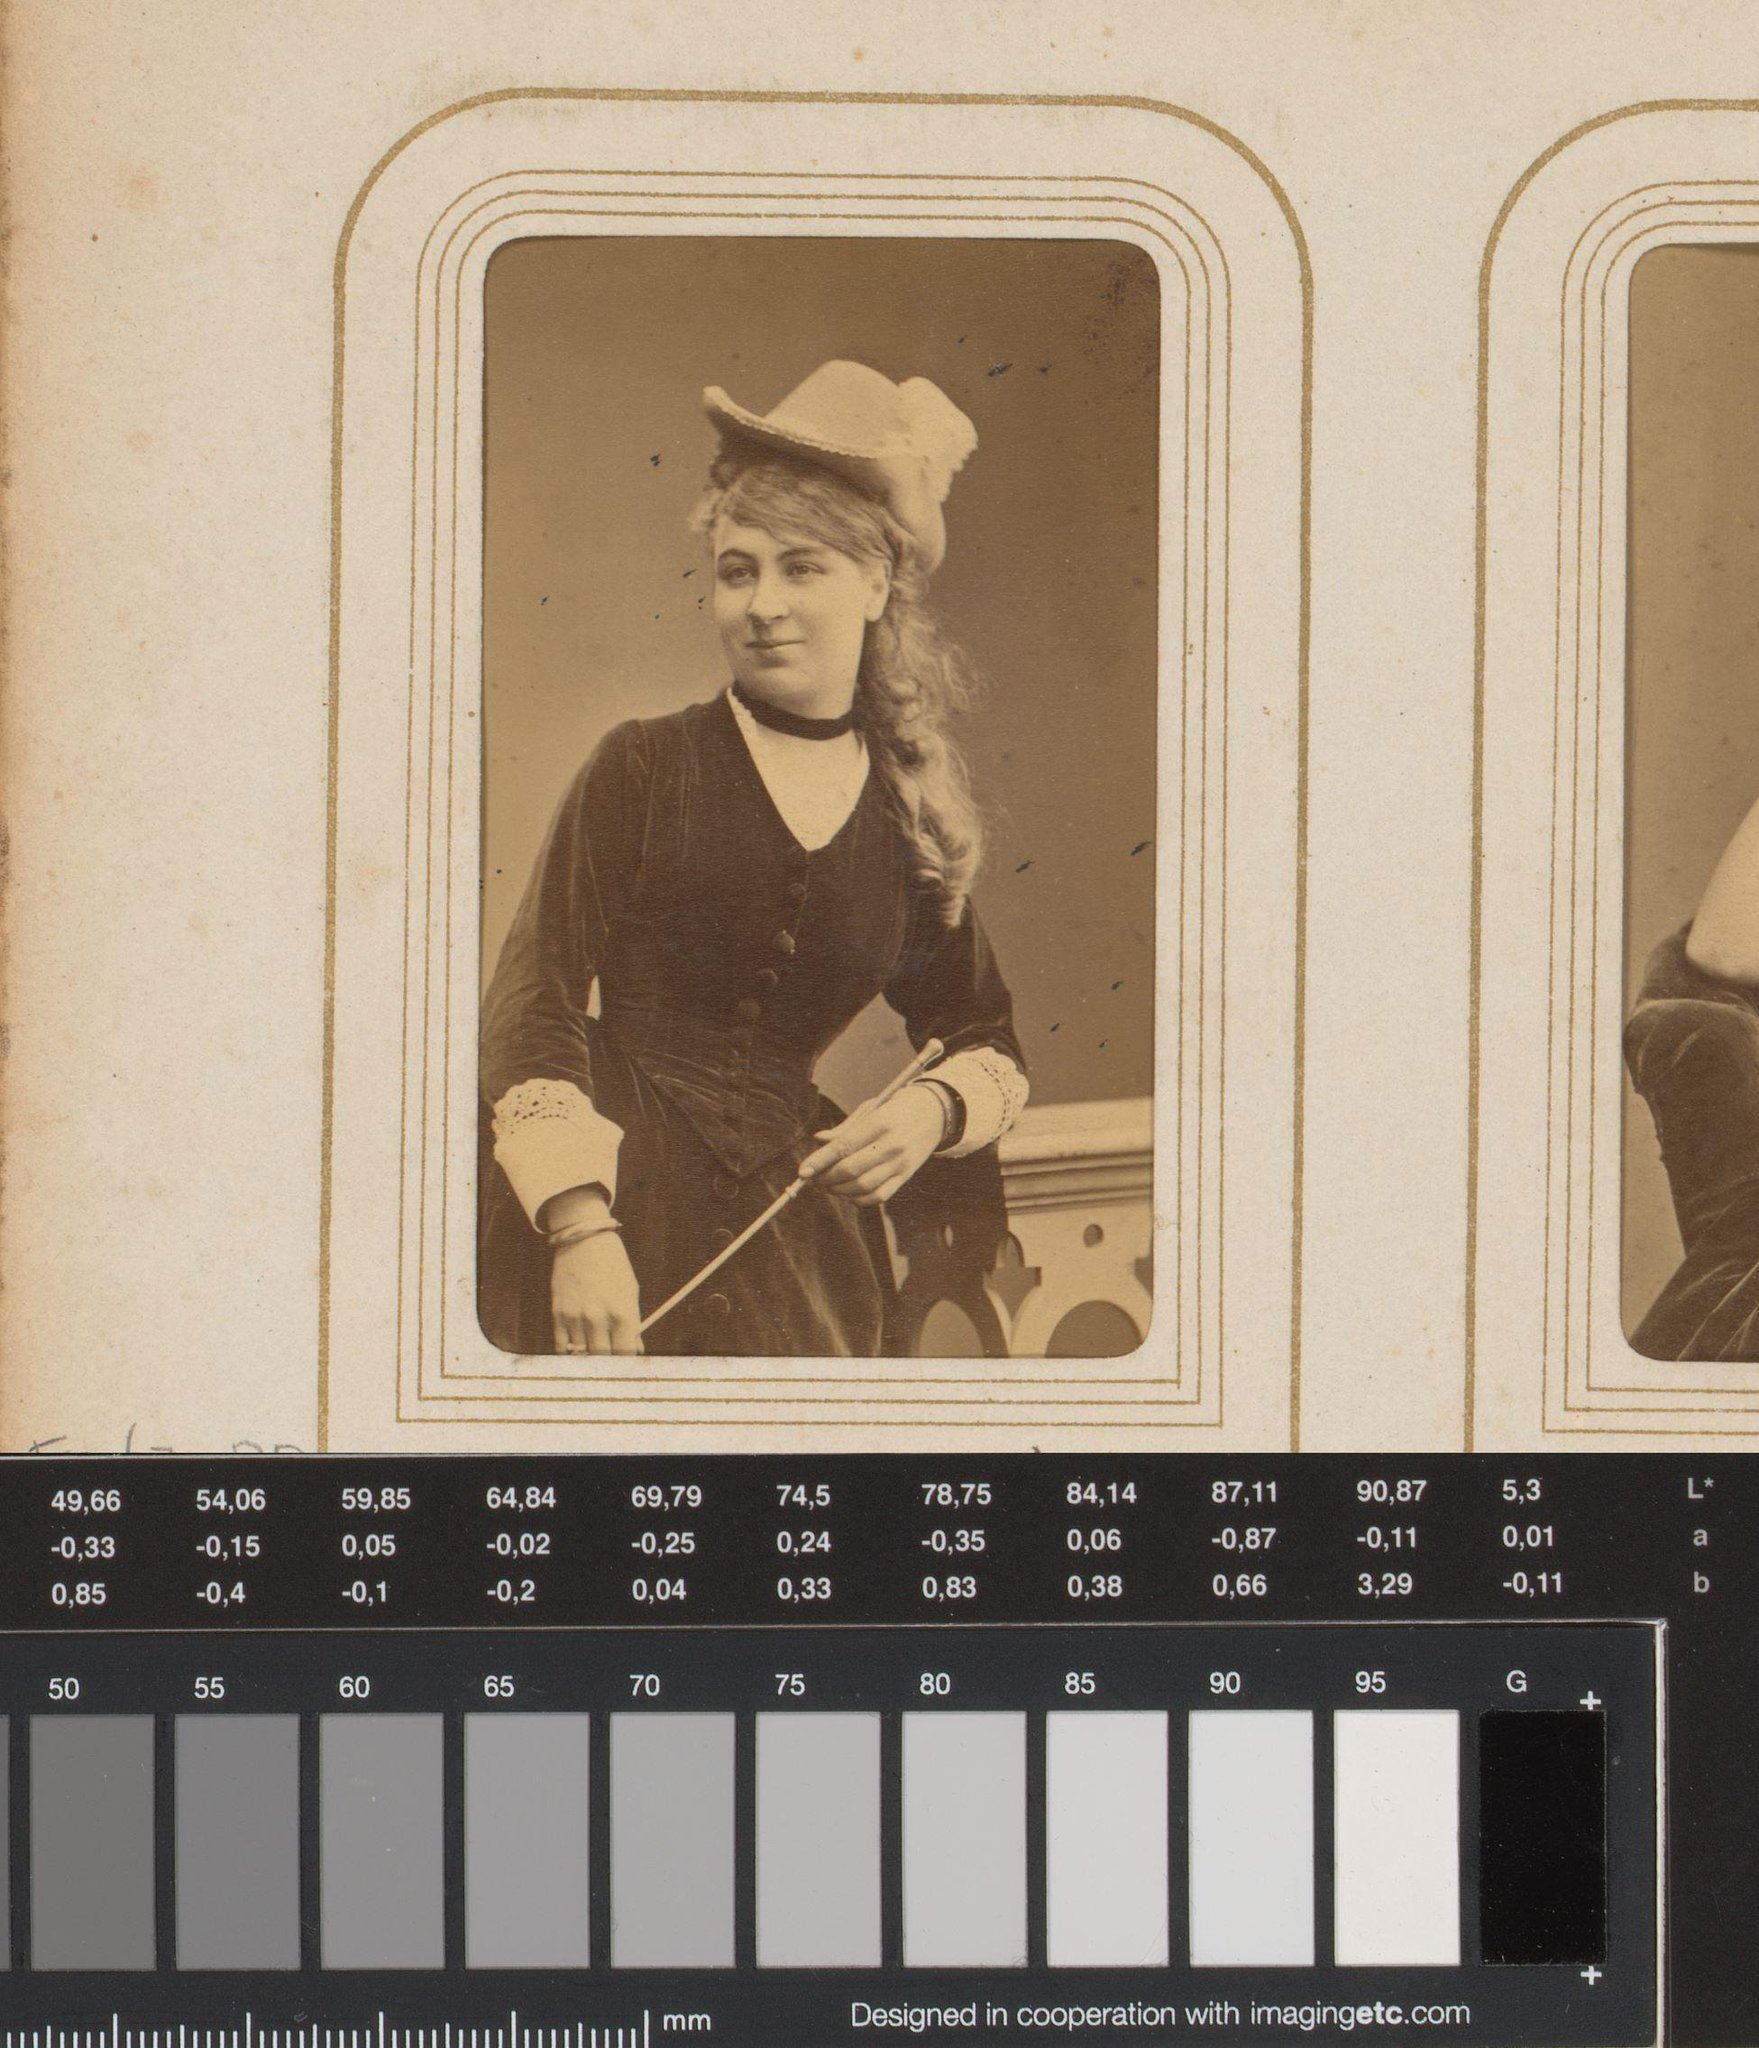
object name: photograph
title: Portret van een vrouw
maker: anatole pougnet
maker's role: publisher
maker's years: 1840-1900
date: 1860-1880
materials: cardboard, photographic support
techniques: albumen print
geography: paris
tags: historical persons - bb - woman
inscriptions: name: ‘Bouvaire’, annotation: ‘Bouvaire (Pougnet)’, inscription: ‘Anatole Pougnet/ Éditeur/ 61, Boulevard Sébastopol/ Paris’